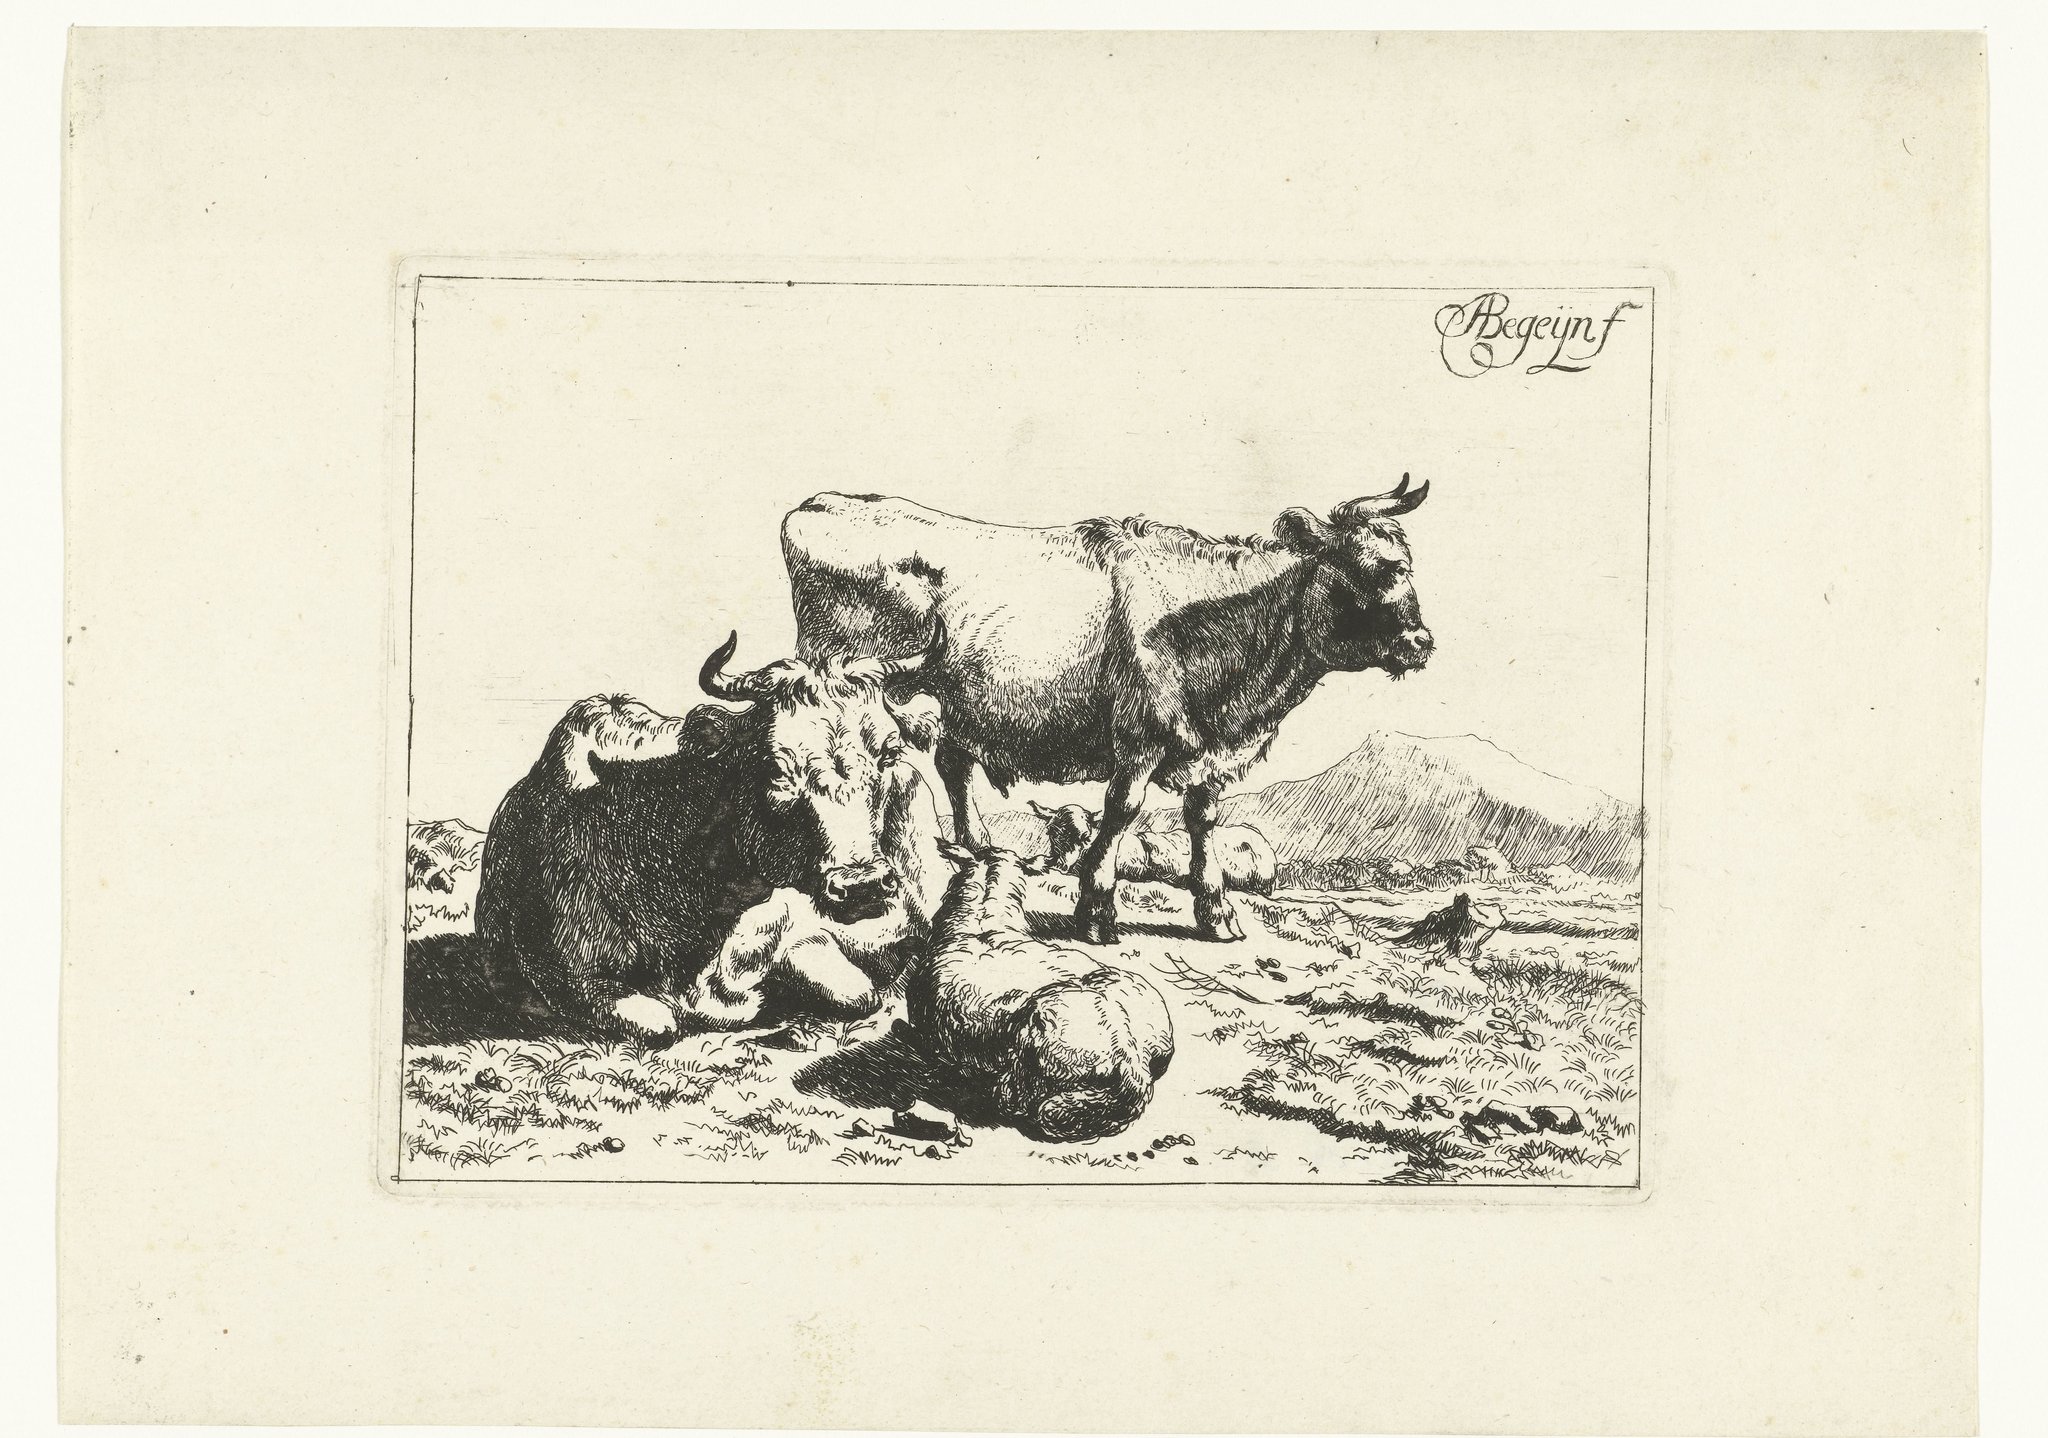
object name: print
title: Staande stier en liggende koe met schaap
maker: abraham jansz begeyn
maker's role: draughtsman, print maker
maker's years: 1637-1697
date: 1647-1697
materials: paper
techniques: etching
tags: bull, cow, sheep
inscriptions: collector's mark: Lugt 240